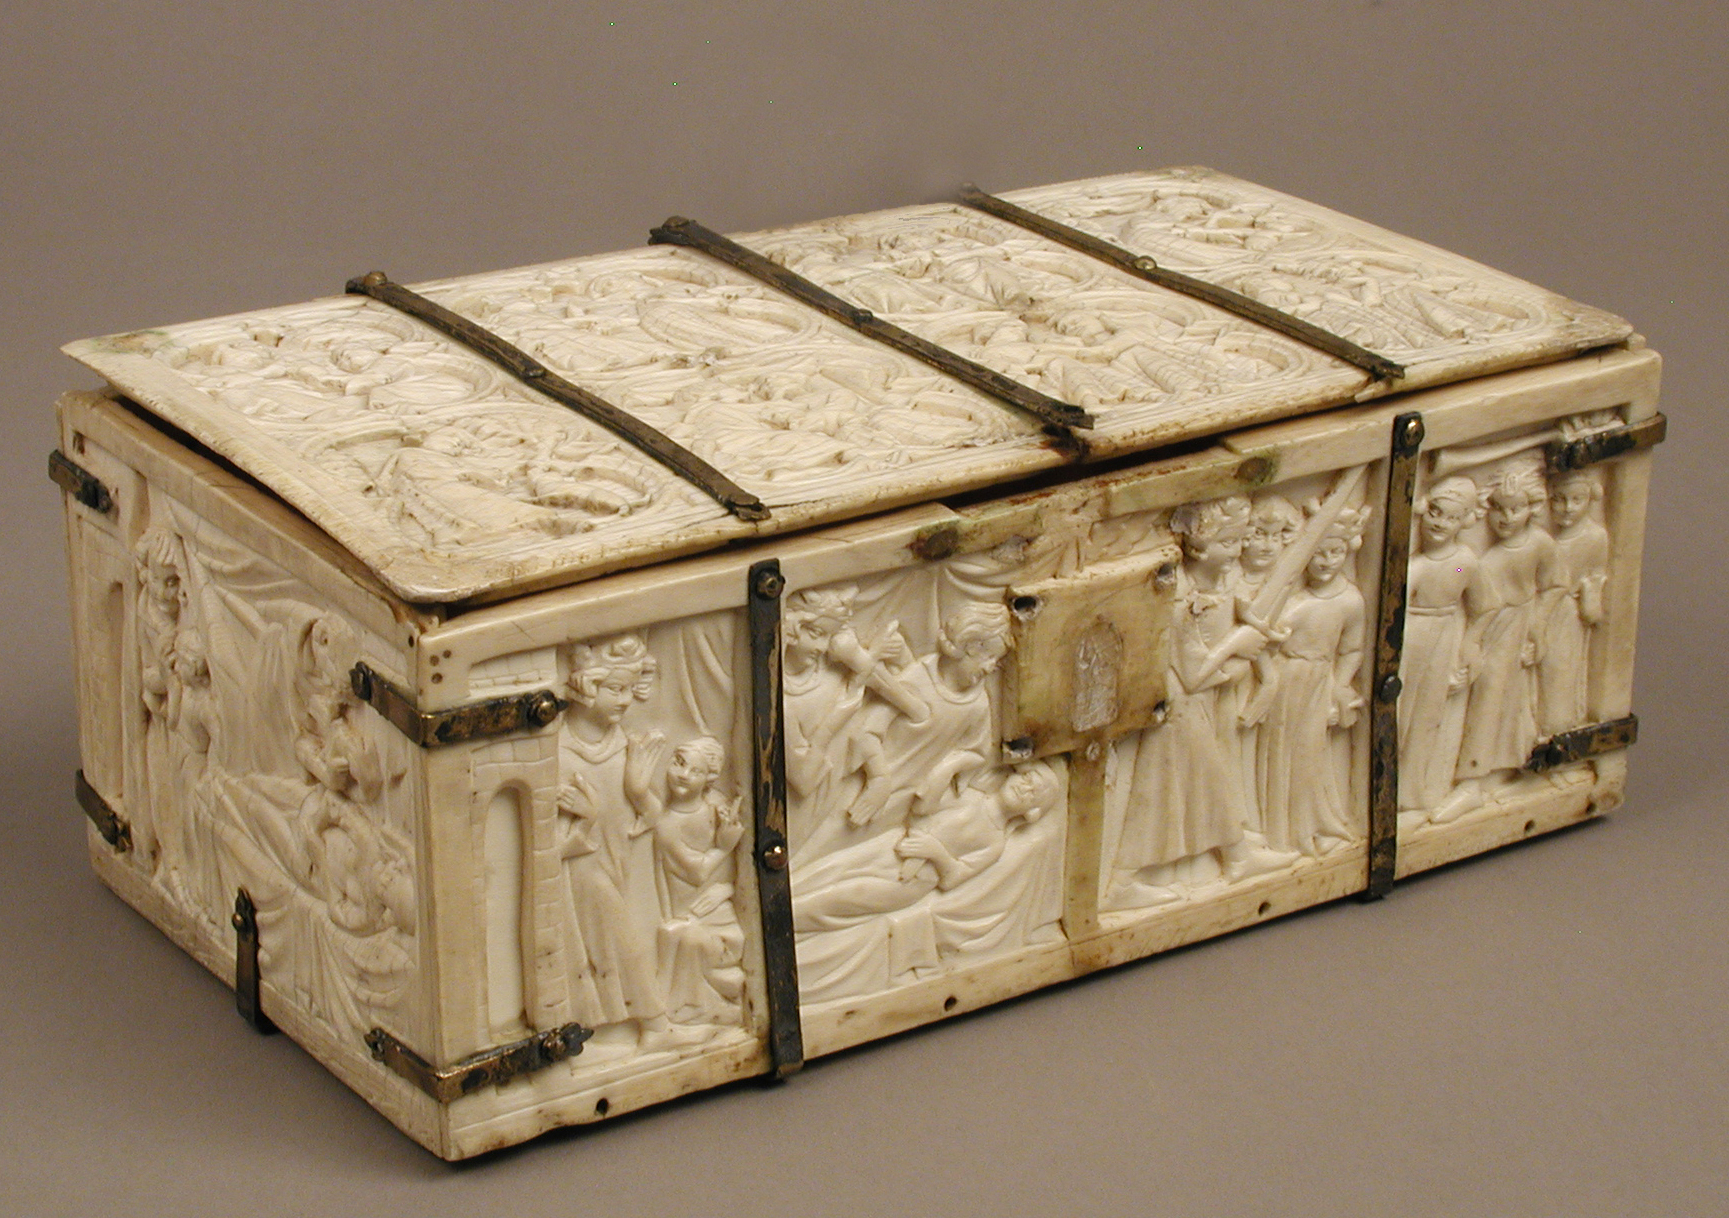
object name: box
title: Box with scenes from the Romance, "The Chatelaine of Vergy"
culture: french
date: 1320-1340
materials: gilt silver, ivory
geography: france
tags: men,women